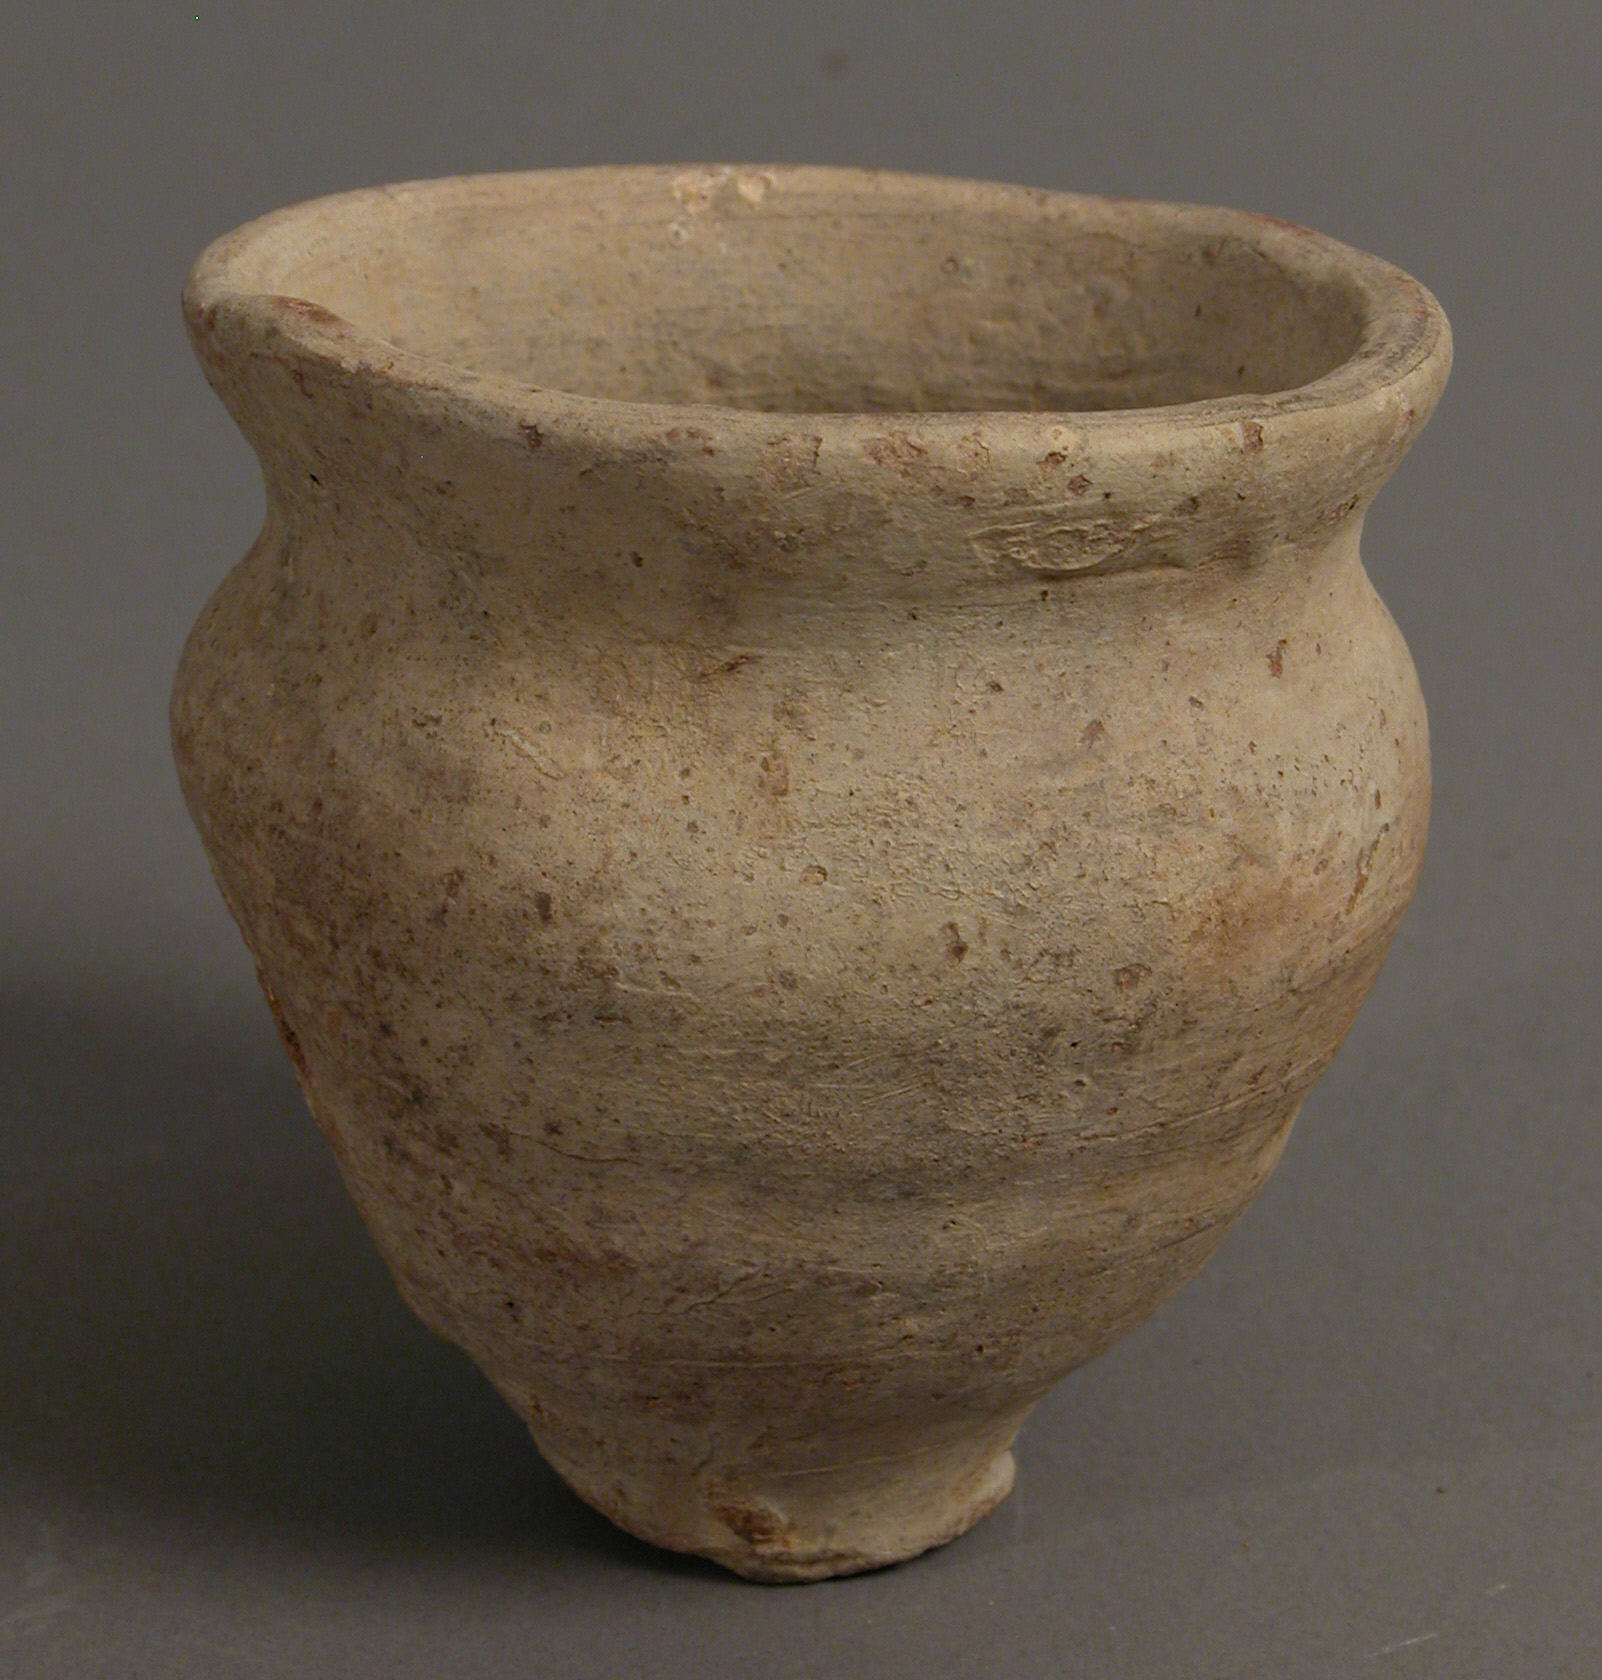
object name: pot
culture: coptic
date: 301-700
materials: earthenware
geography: egypt